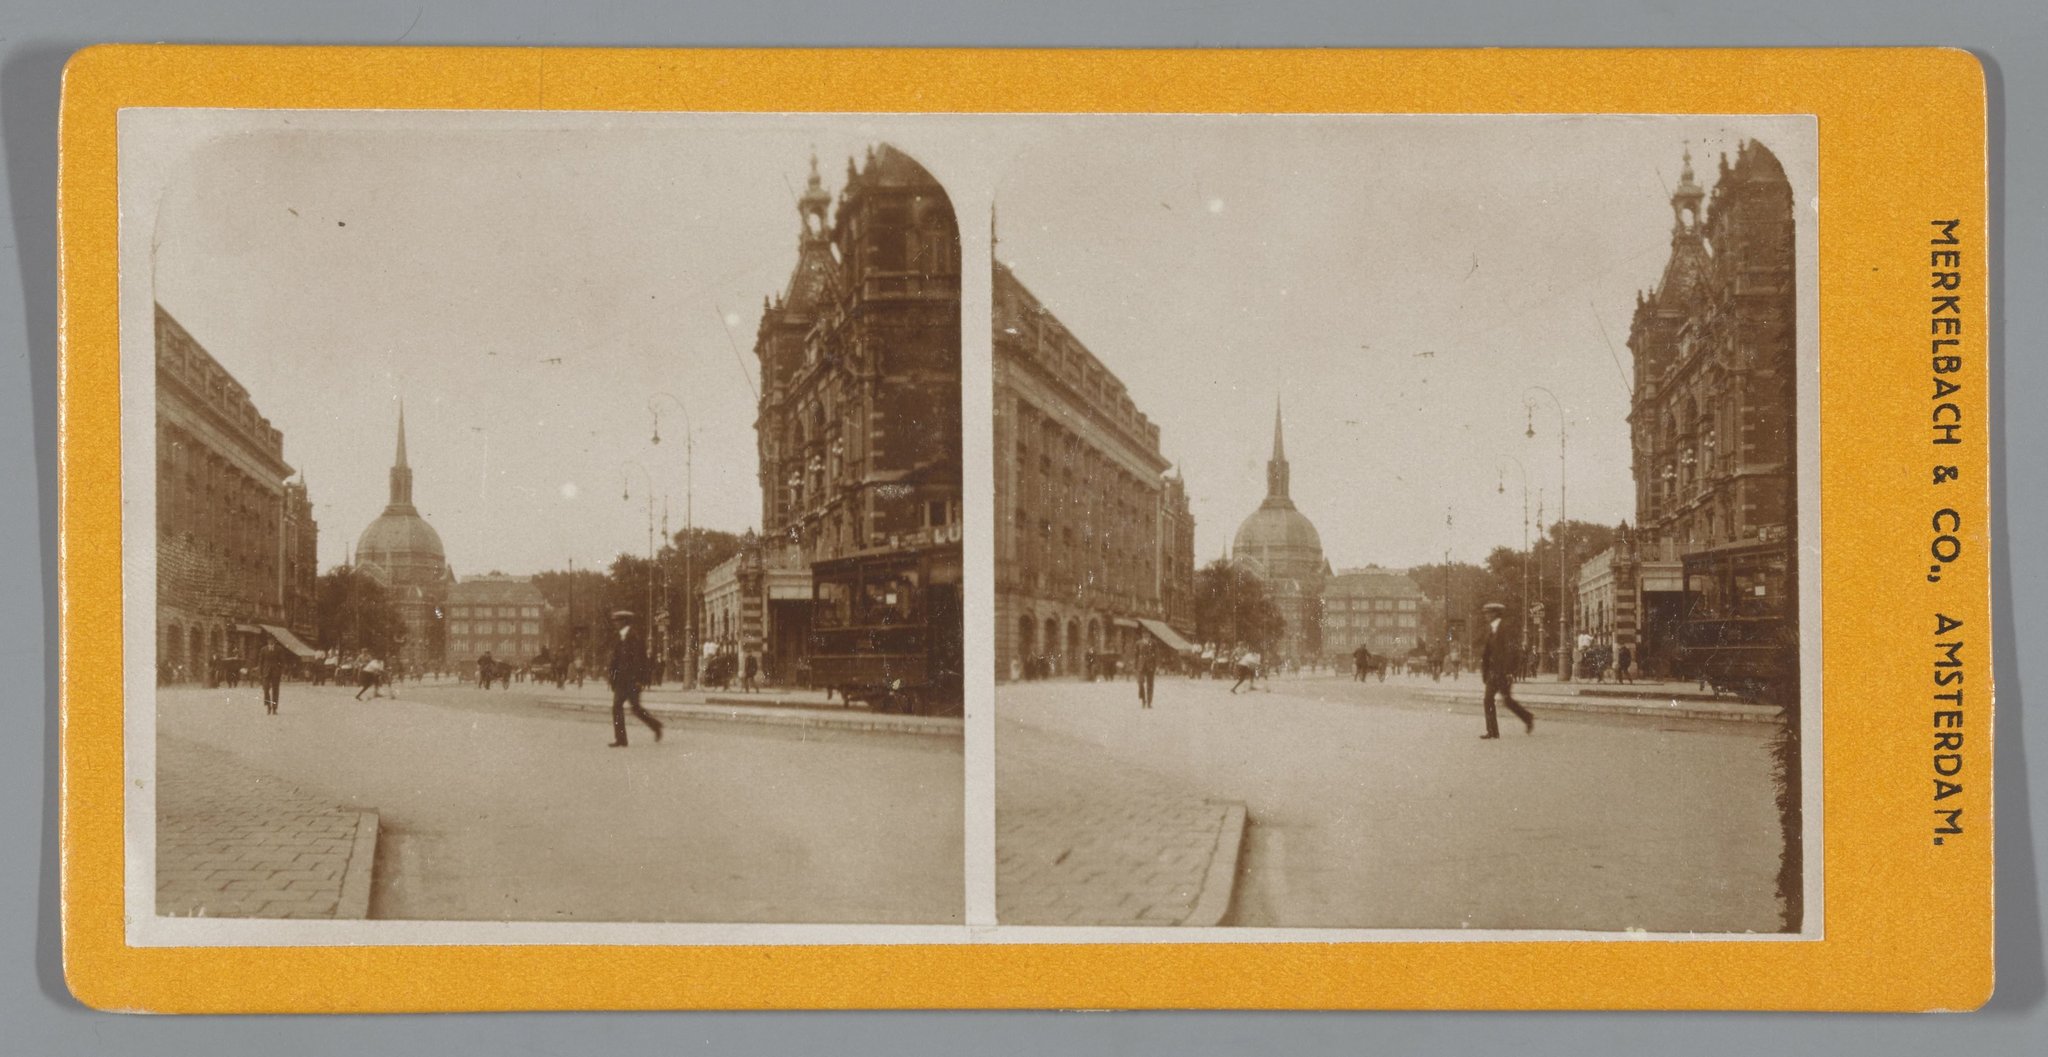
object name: stereograph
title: Aardrijkskundige beeldengalerij, verzameld door M.J. Broekhuijsen, hoofd eener school te Amsterdam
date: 1909-1922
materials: paper, cardboard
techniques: collodion silver print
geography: amsterdam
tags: square, place, circus, etc.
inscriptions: number: ‘16.’, inscription: ‘Rechts de Stadsschouwburg (...) de Koepelkerk.’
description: Fotografische heruitgave van oorspronkelijke stereokaart.